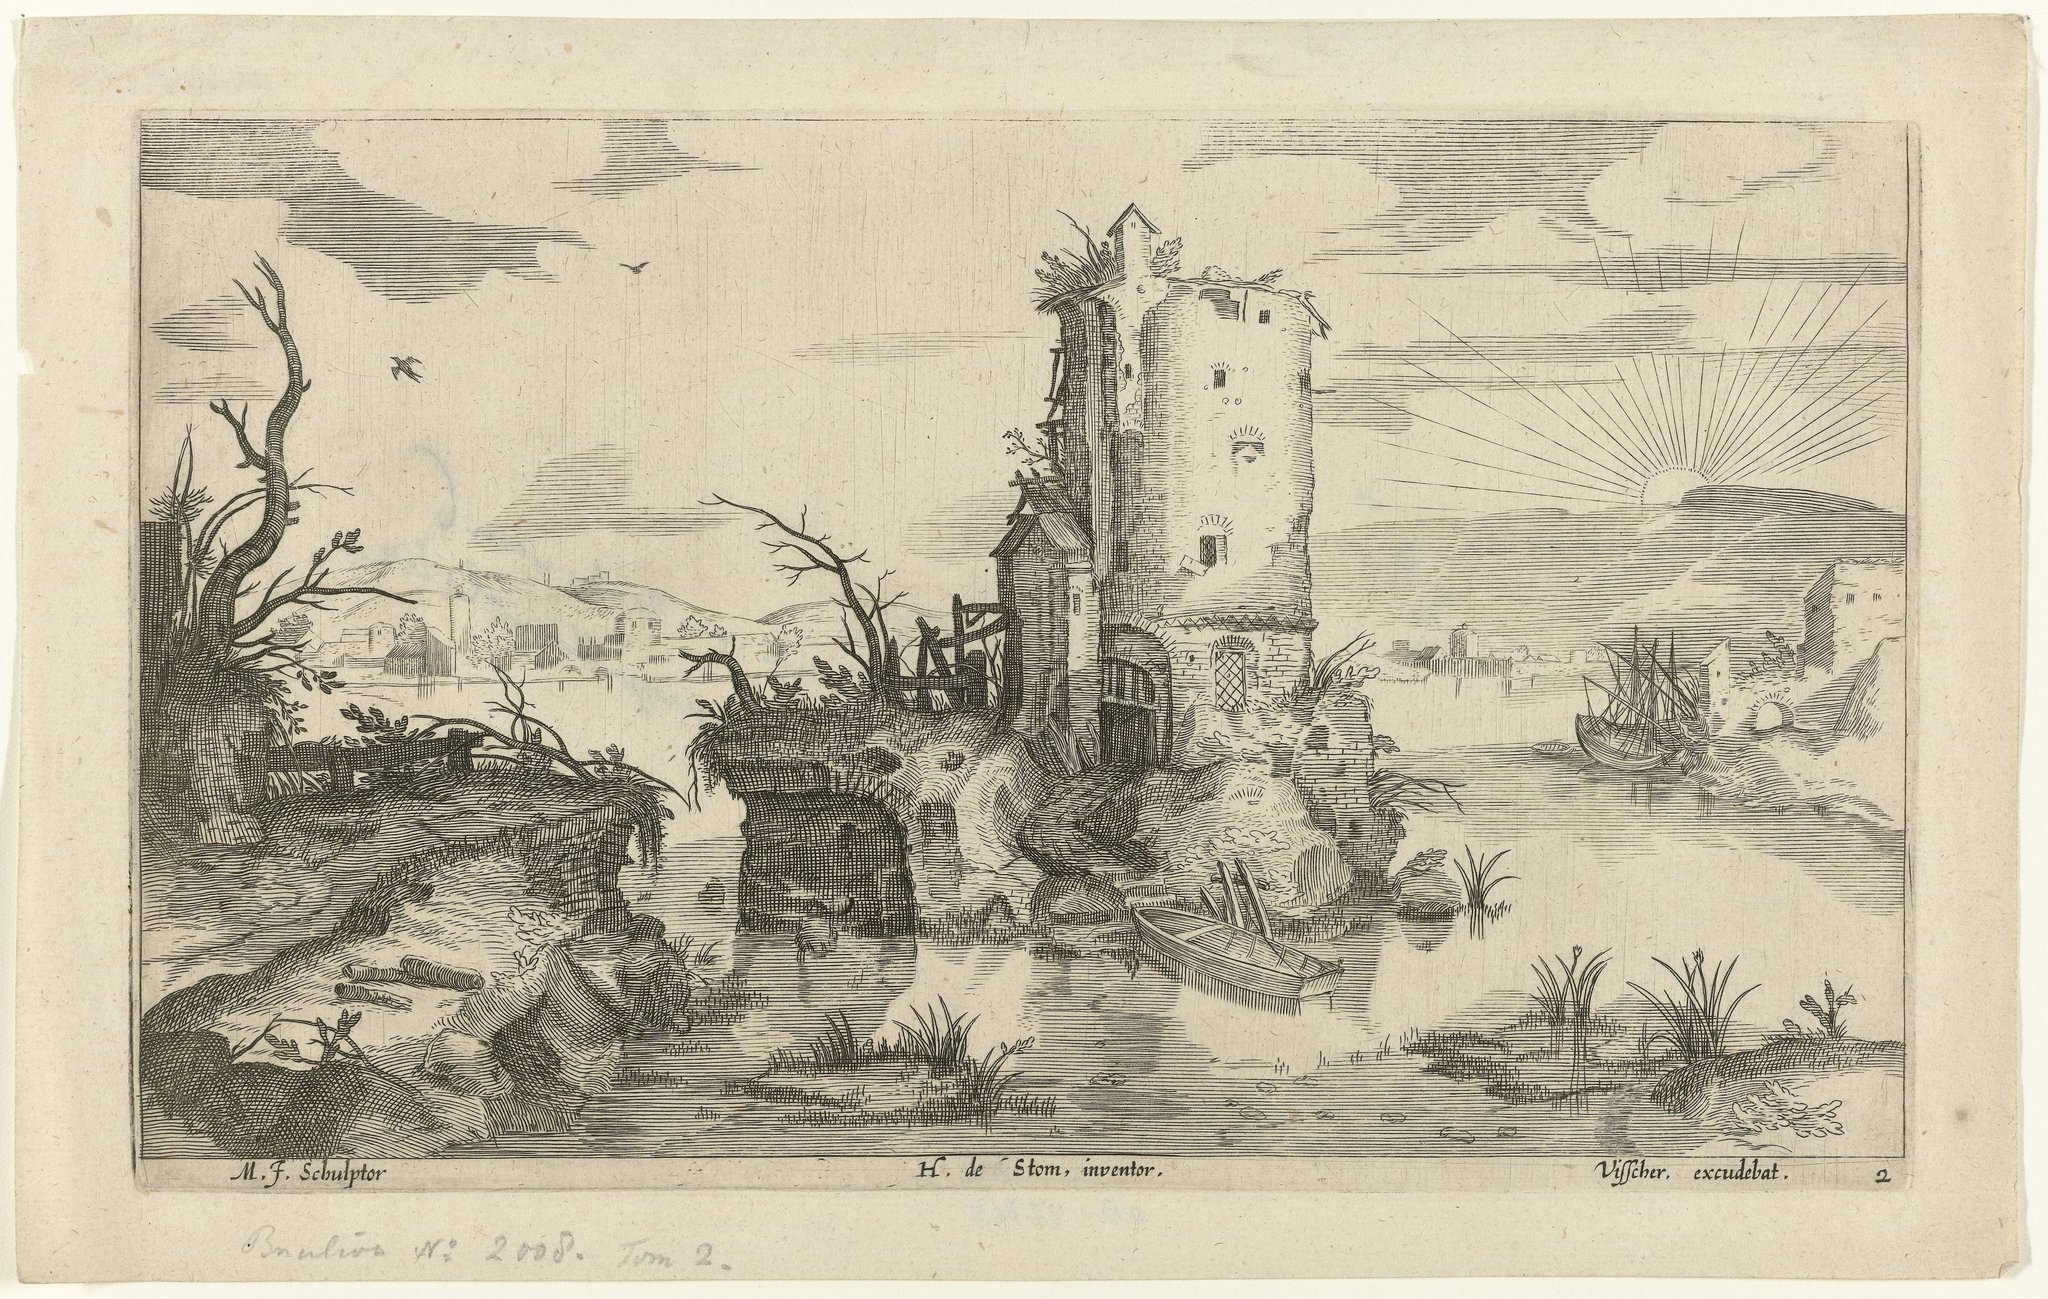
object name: print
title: Landschap met ruïne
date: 1610-1614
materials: paper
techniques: engraving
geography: amsterdam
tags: landscape with ruins - ii - ideal landscapes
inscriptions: collector's mark: Lugt 2227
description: Landschap met ruïne op een eiland in een rivier. Op de achtergrond een opkomende zon. Prent uit een serie van zes met landschappen.